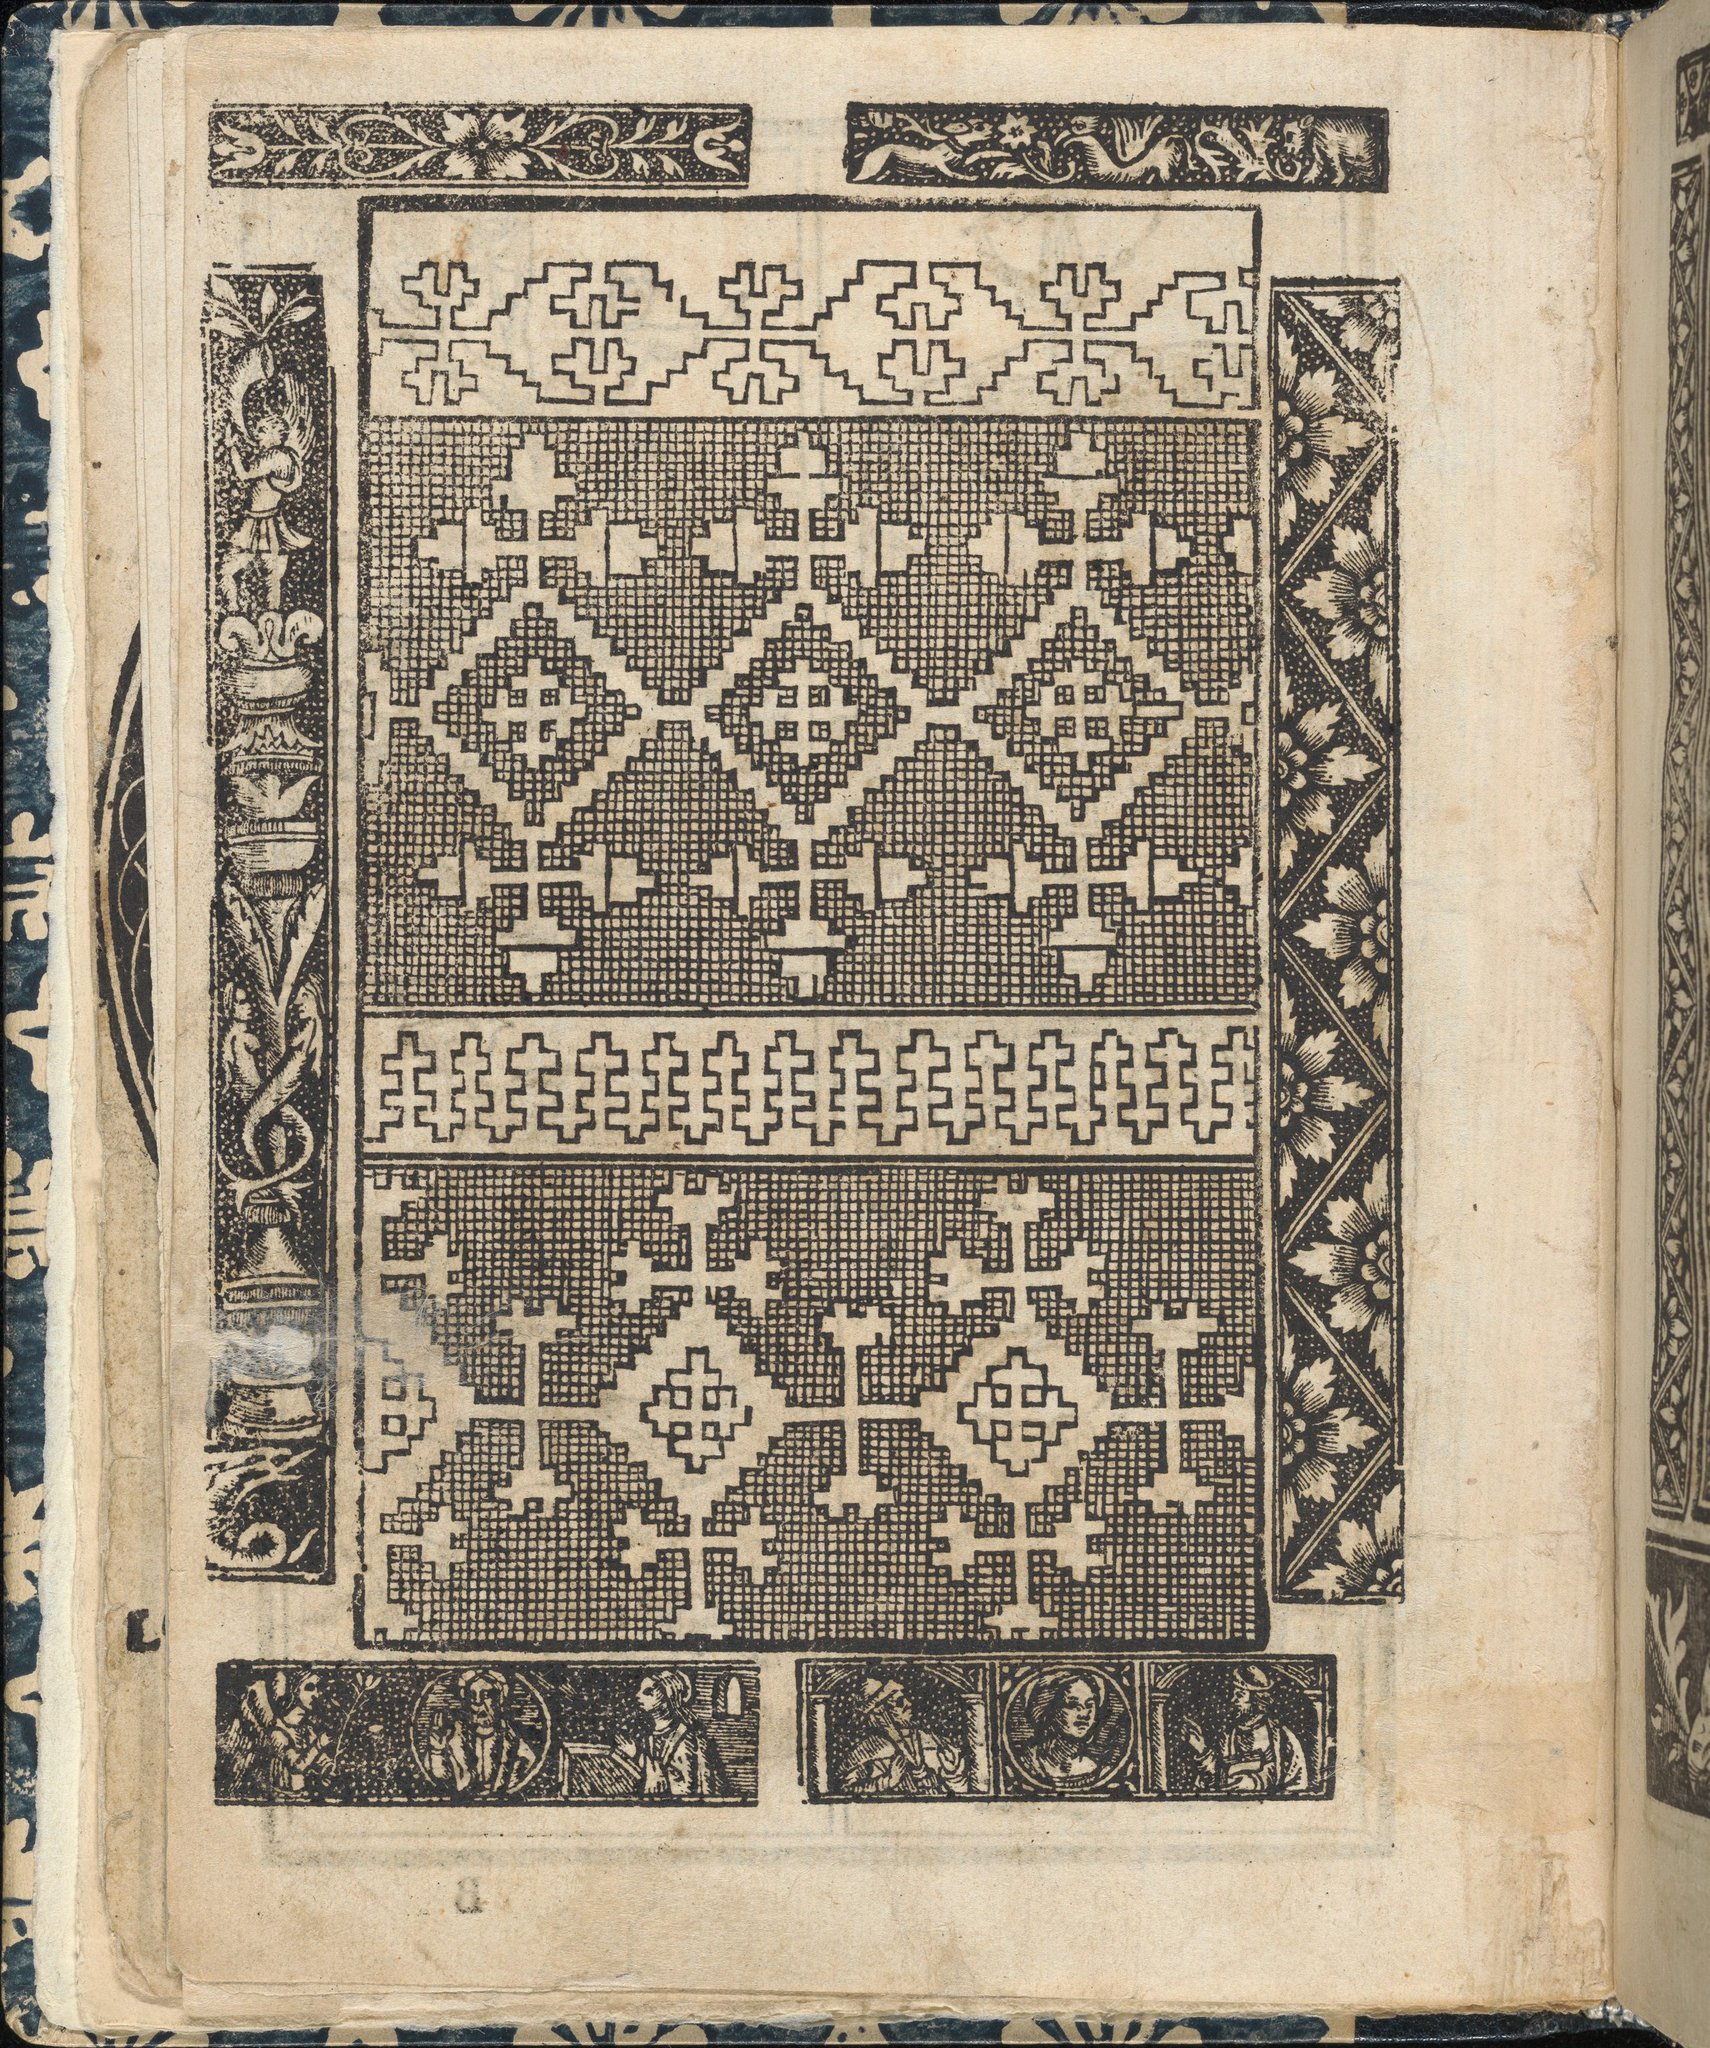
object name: book print ornament architecture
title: Essempio di recammi, page 9 (verso)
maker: giovanni antonio tagliente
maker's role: author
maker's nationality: italian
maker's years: 1465-1528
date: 1530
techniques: woodcut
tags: ornament